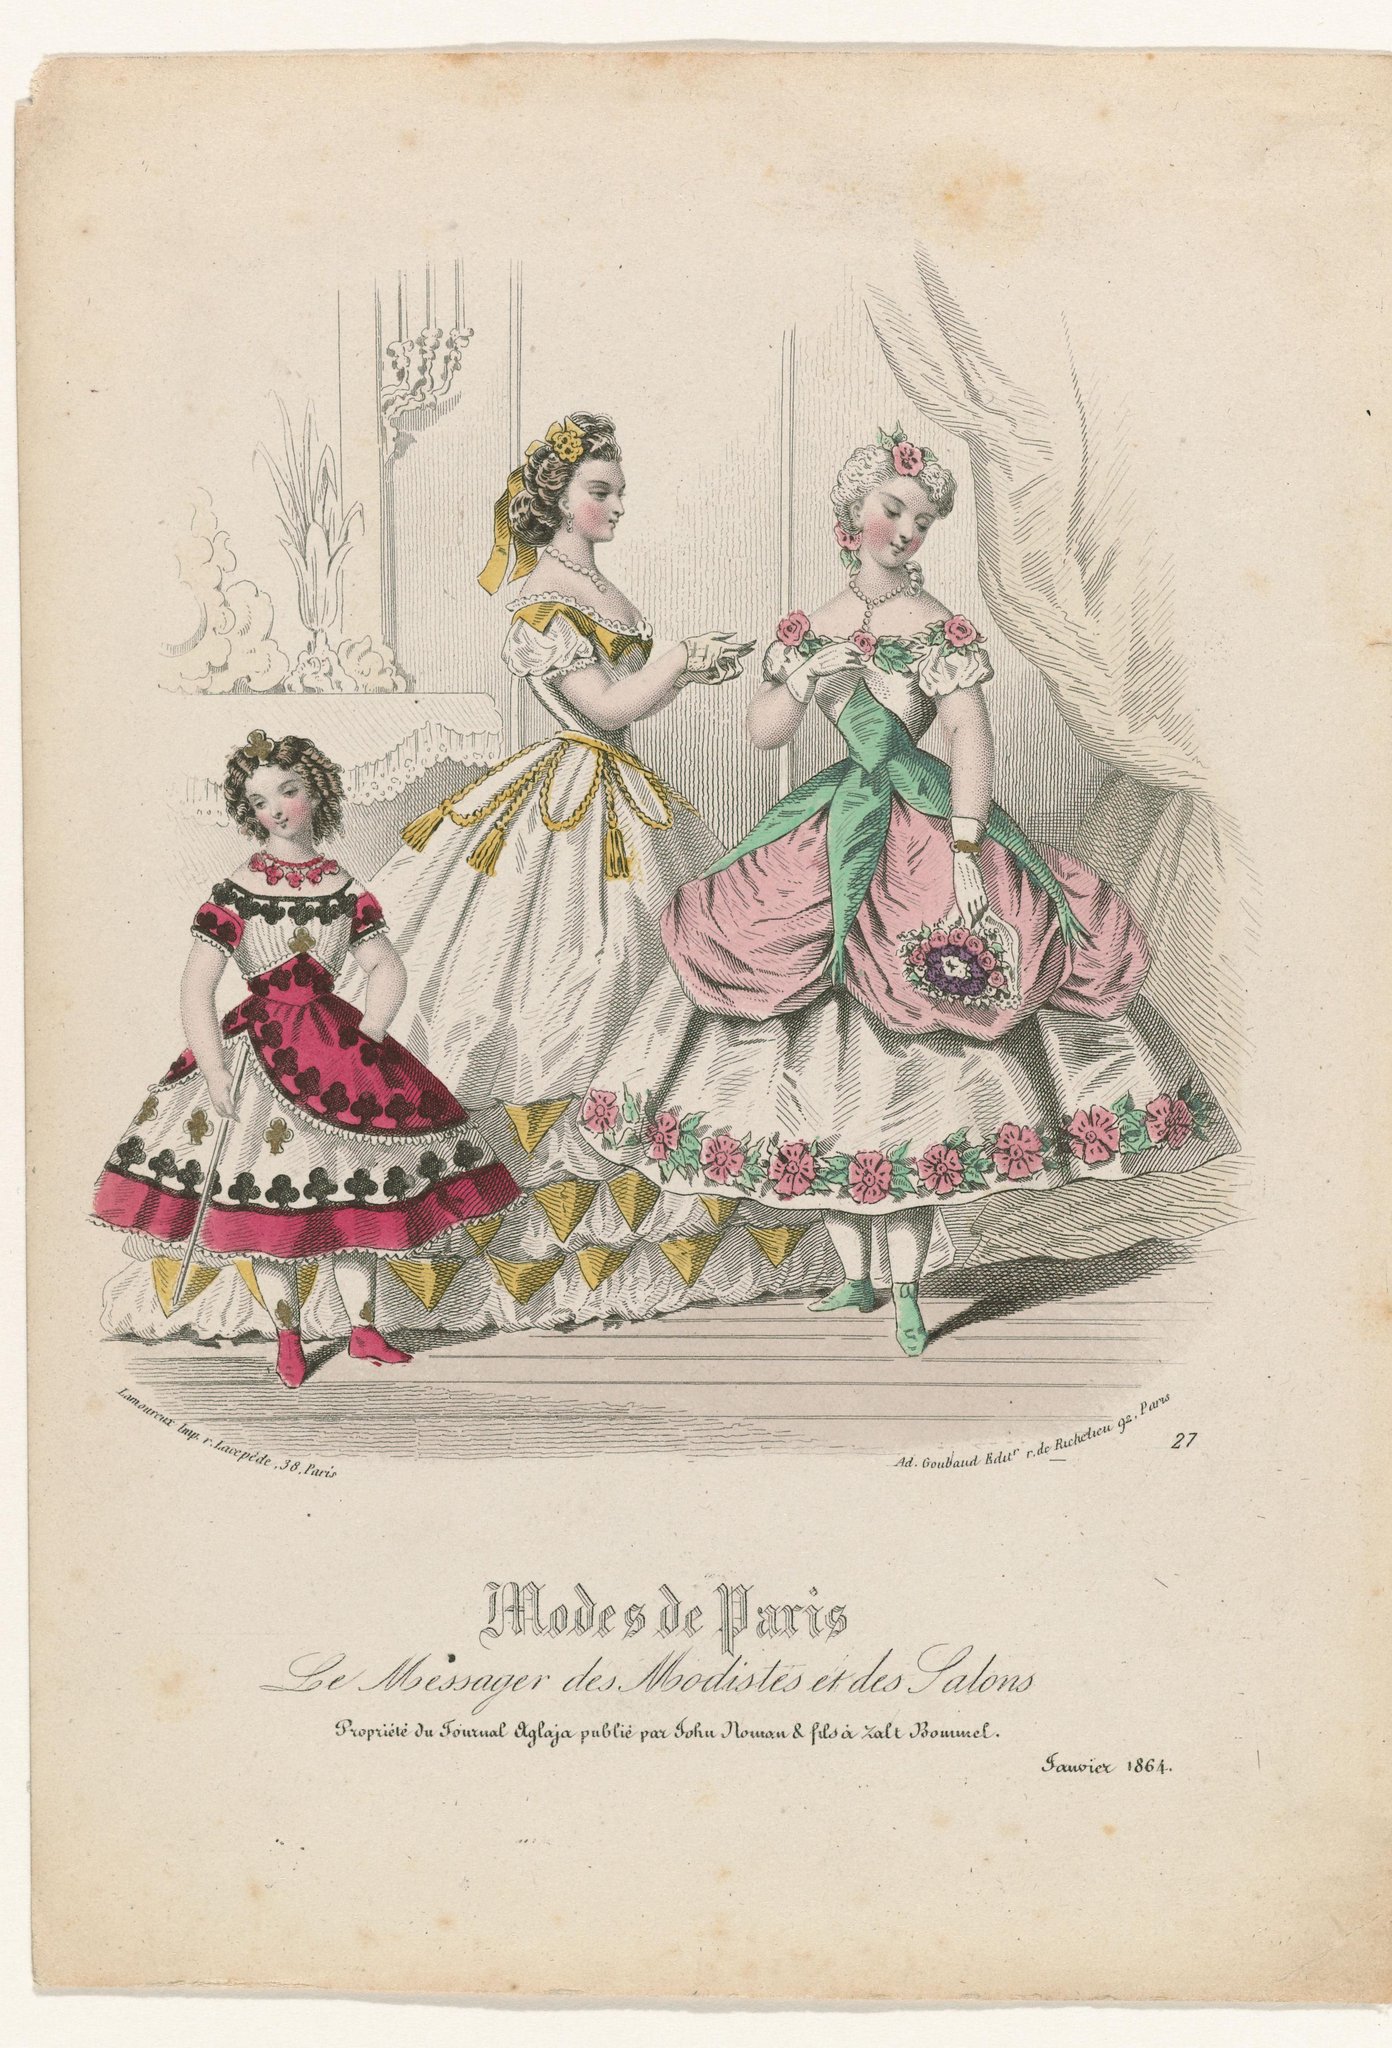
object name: fashion print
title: Le Messager des Modistes et des Salons, Modes de Paris, Journal Aglaja, janvier 1864, No. 27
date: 1864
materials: paper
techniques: engraving, hand coloring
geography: zaltbommel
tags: cut flowers; nosegay, bunch of flowers, dress, gown: evening dress (+ women's clothes), dress, gown: evening dress (+ girls' clothes), fashion plates, gloves, mittens, etc. (+ women's clothes)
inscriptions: title: ‘Modes de Paris / Le Messager des Modistes et des Salons.’, caption: ‘Propriété du Journal Aglaja publié par John Noman & fils à Zalt Bommel.’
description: Een vrouw en twee meisjes in avondjaponnen. De prent werd opgenomen in Aglaja (1848-1864), maandboekje voor dames handwerken, uitgegeven door A. C. Kruseman te Haarlem.